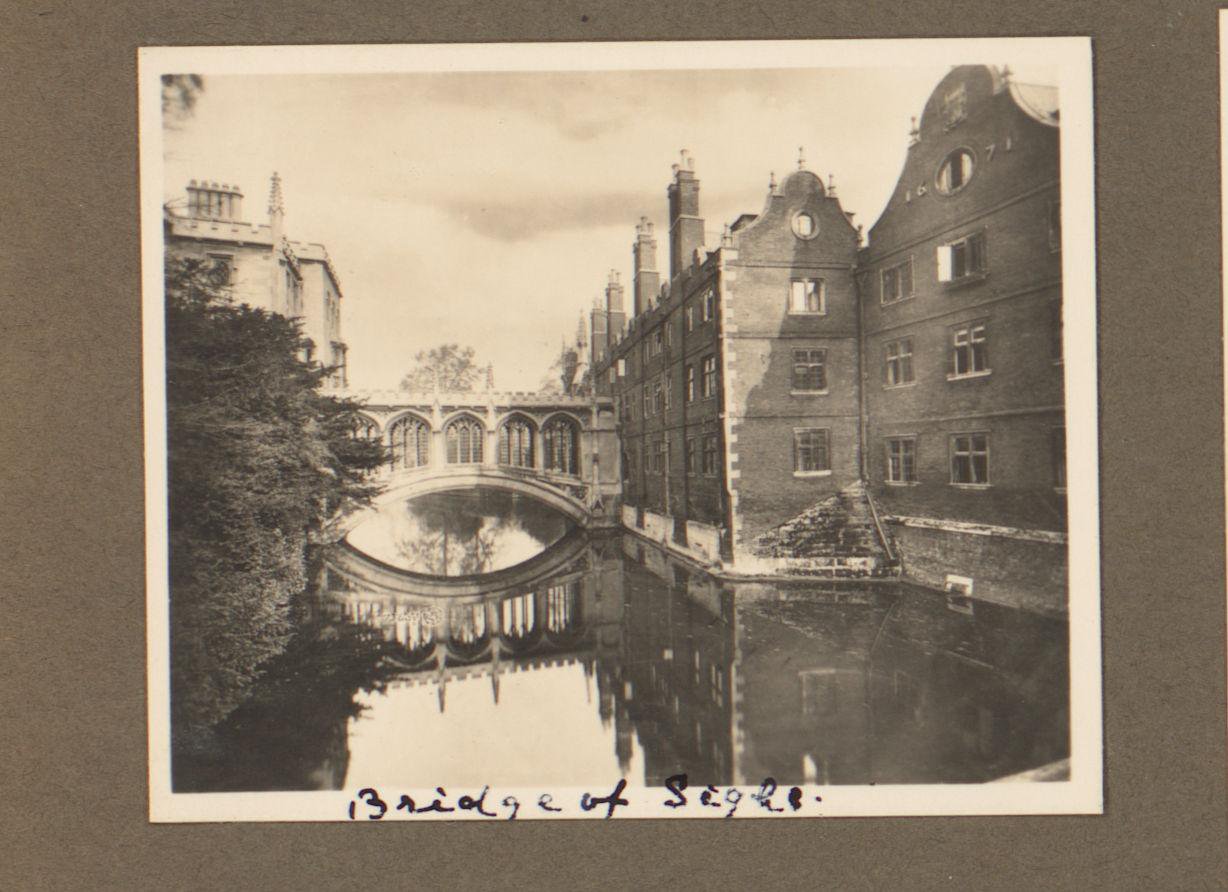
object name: album leaf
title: Bridge of Sighs, Cambridge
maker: Anonymous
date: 1932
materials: paper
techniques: gelatin silver print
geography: cambridge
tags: university building, college, bridge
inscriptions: inscription: ‘Bridge of Sighs’